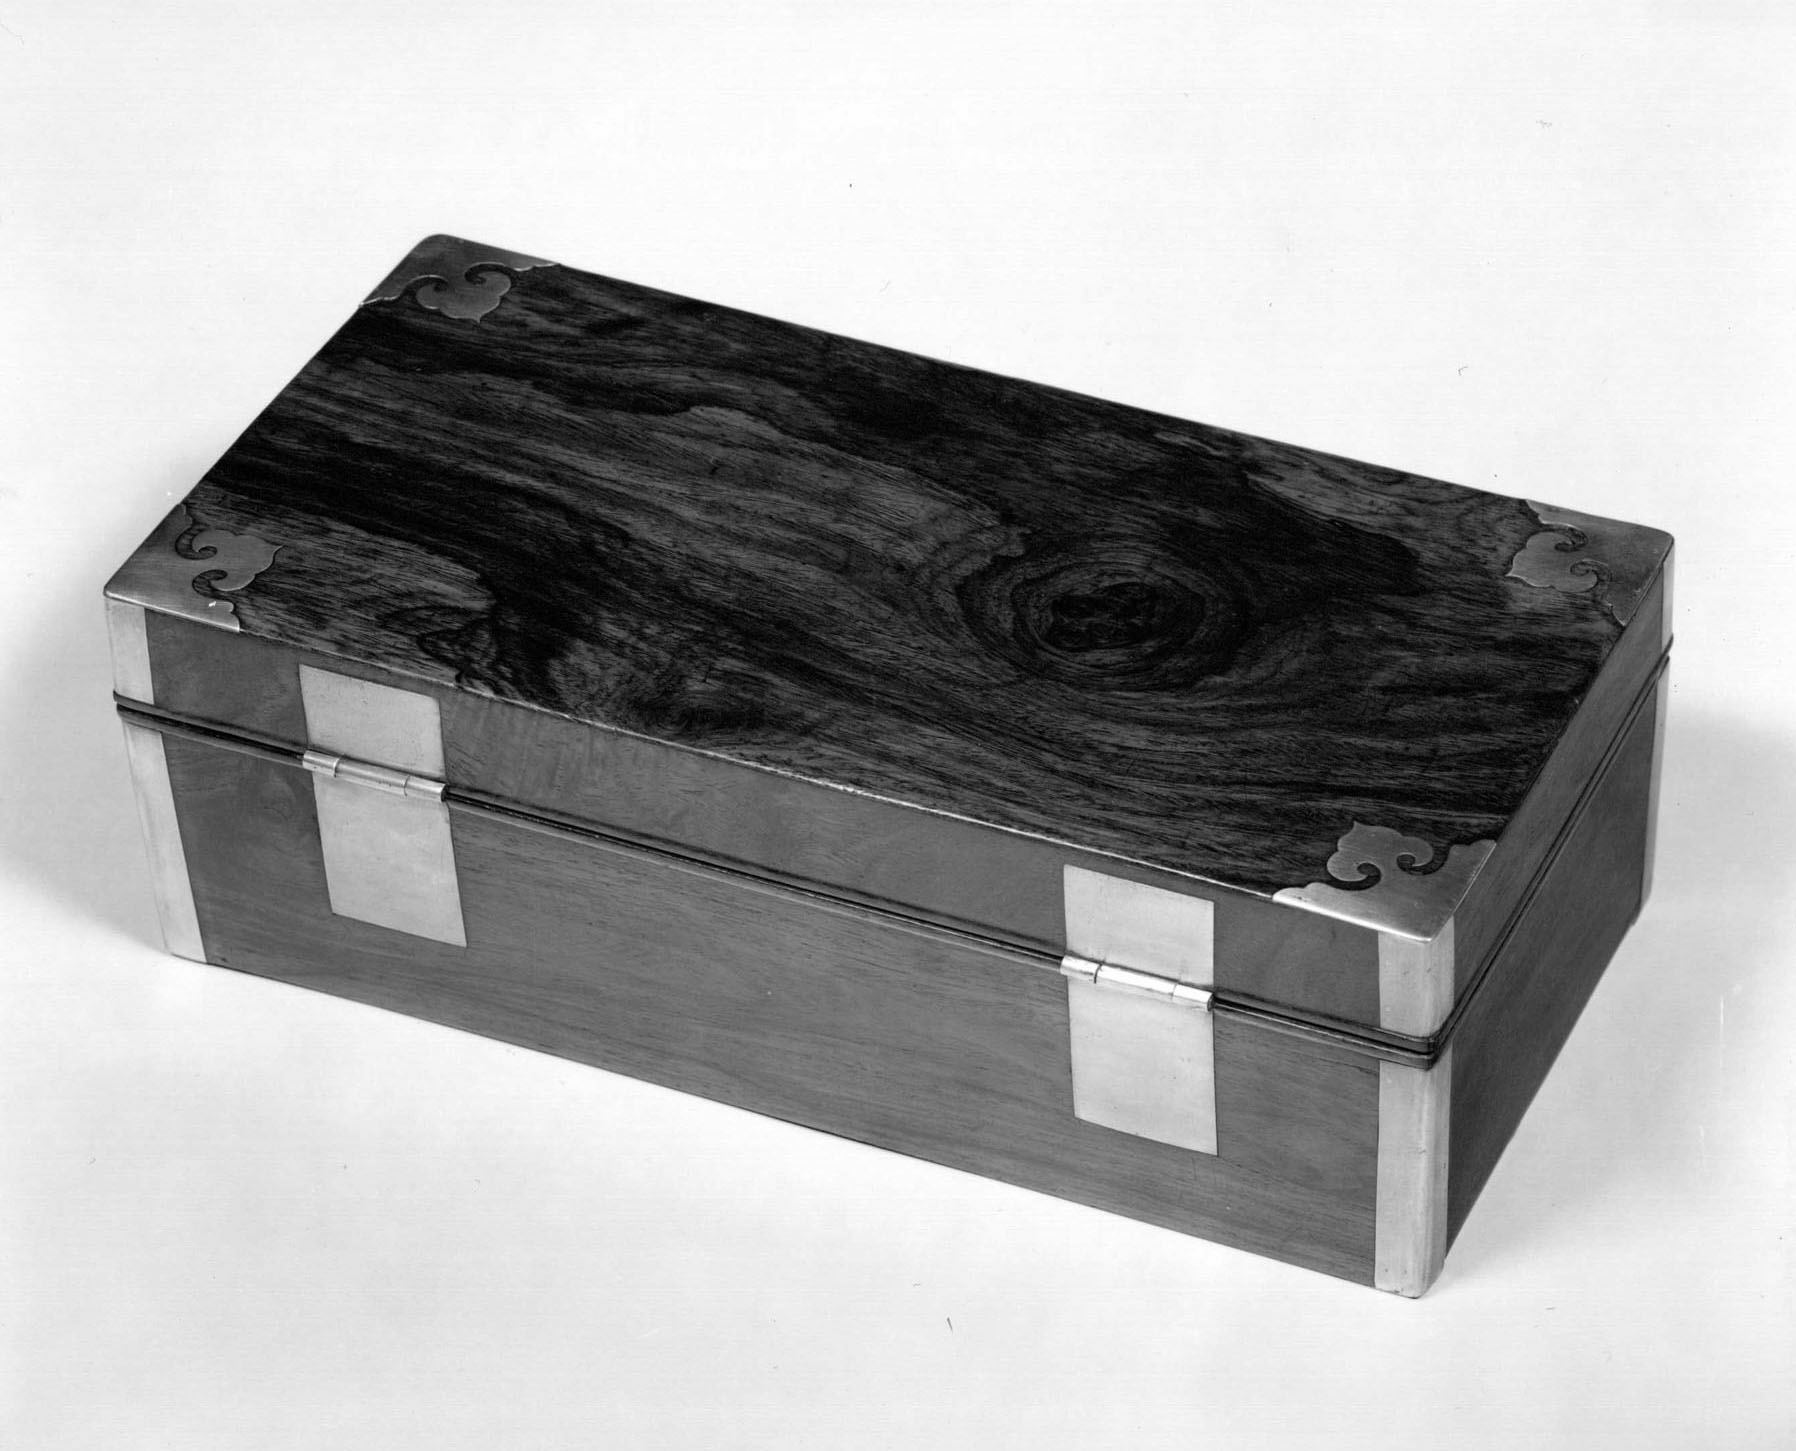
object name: writing box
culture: chinese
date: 1601-1700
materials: wood